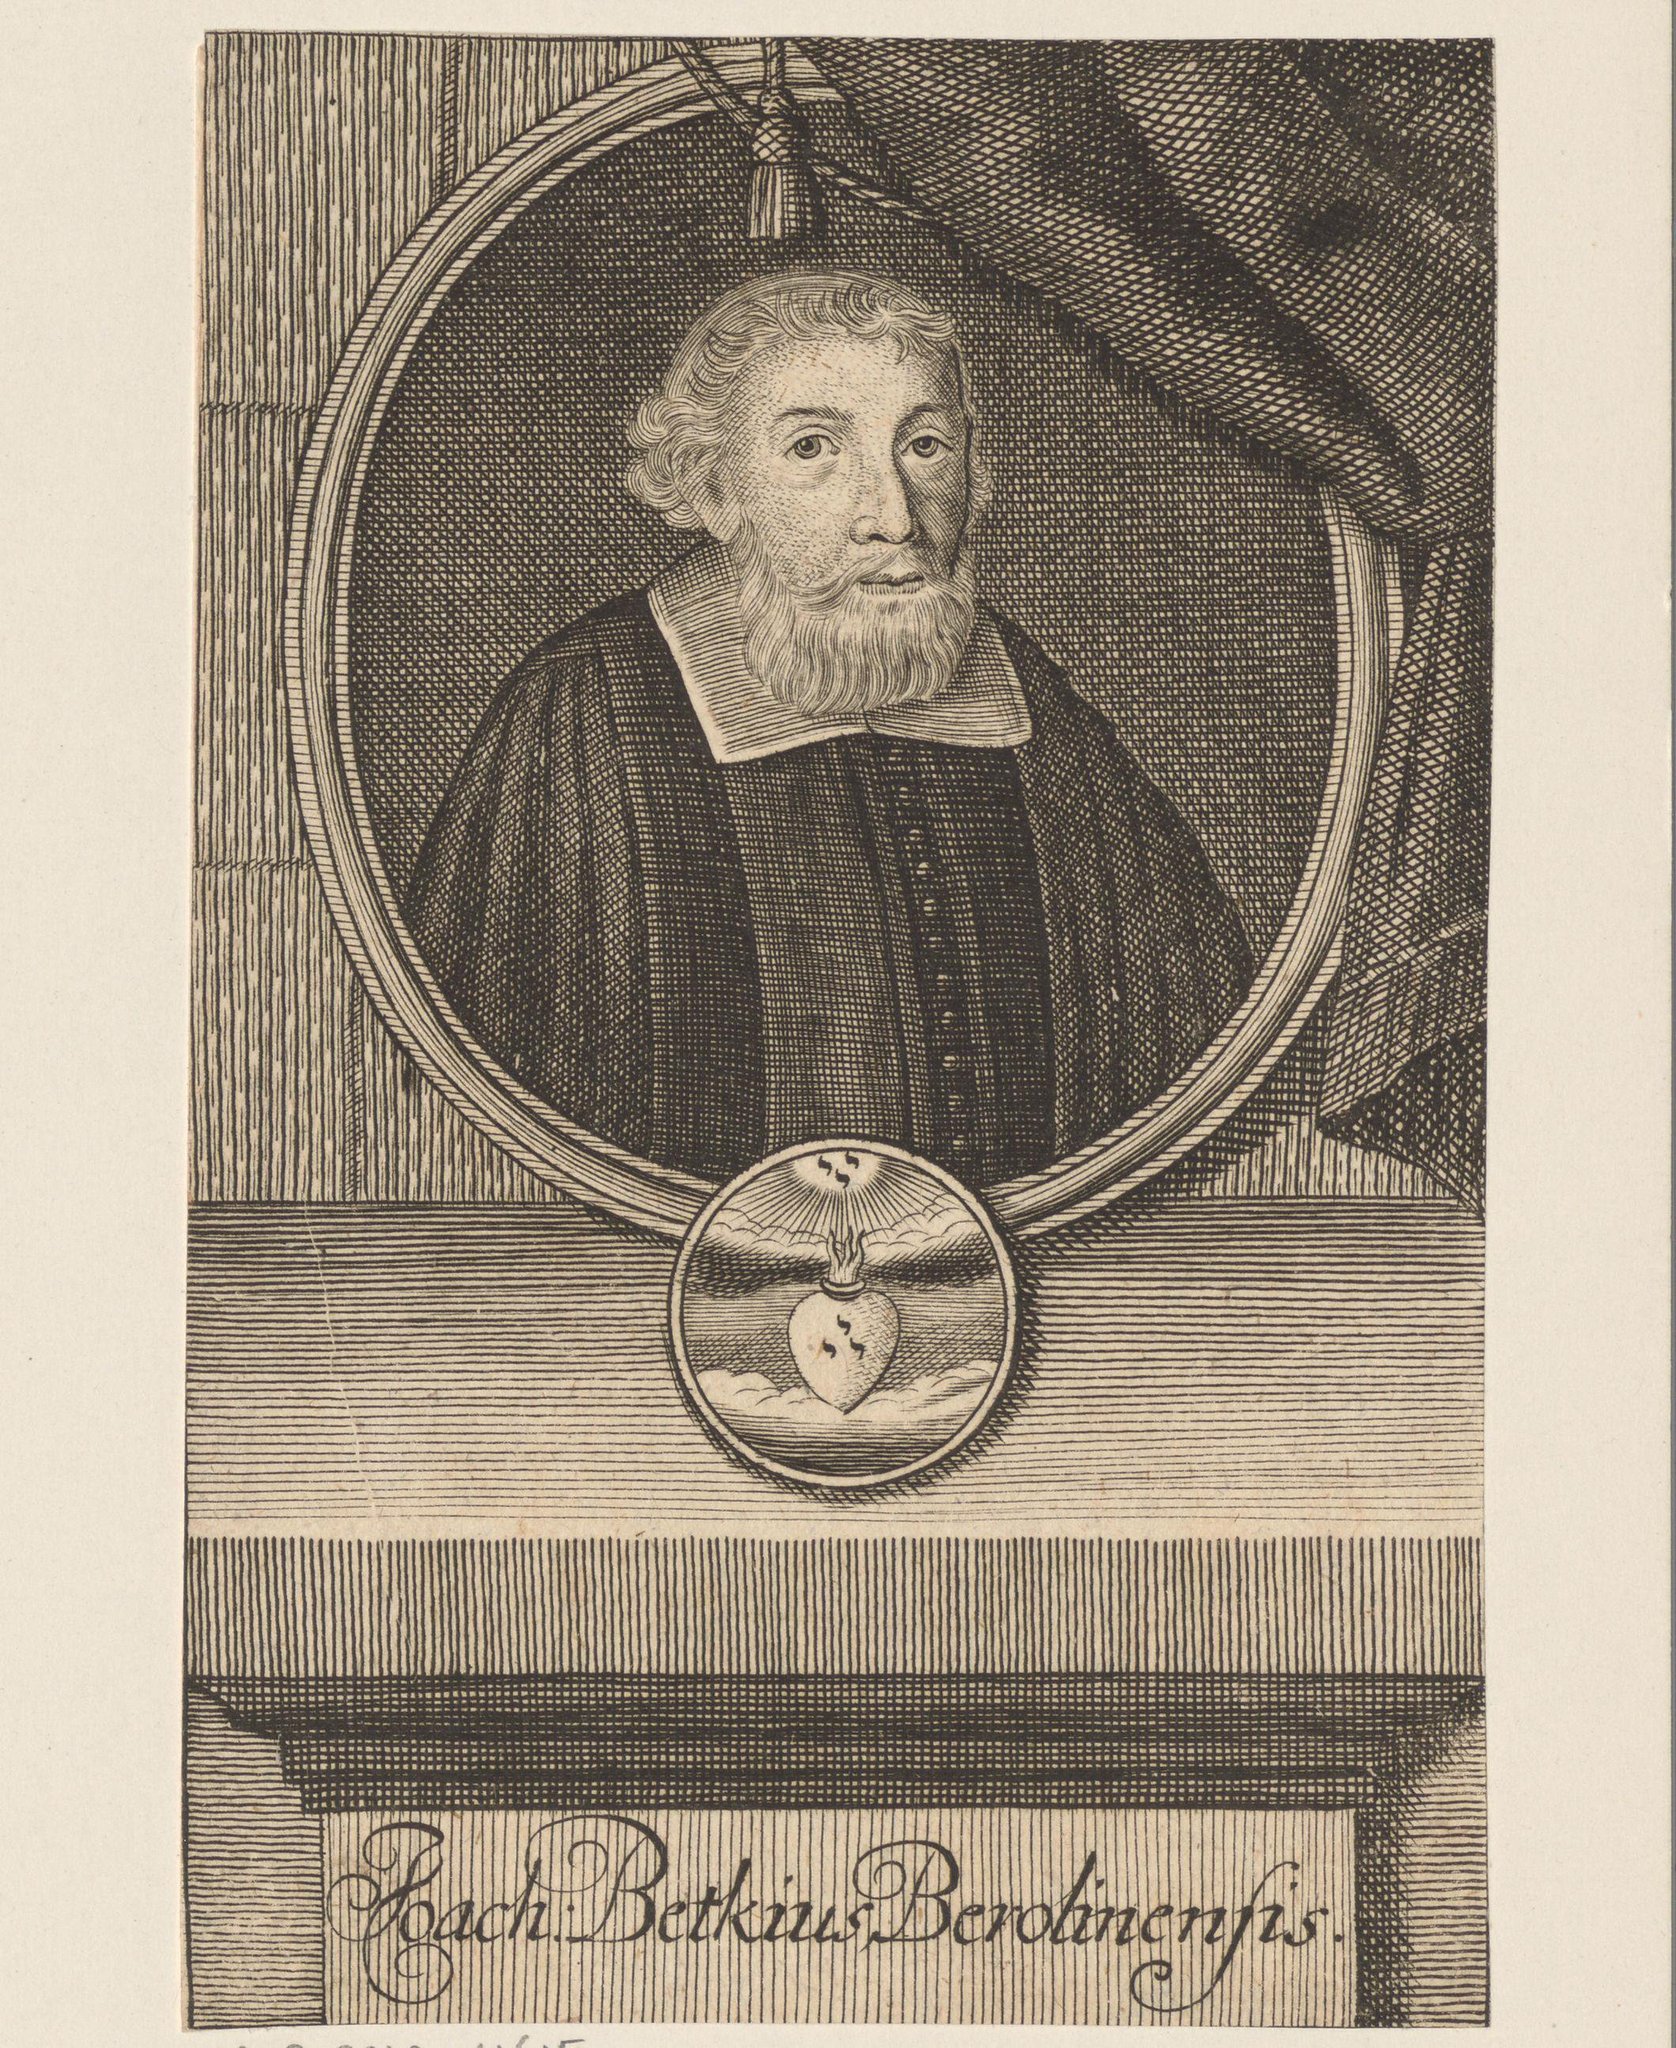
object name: print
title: Portret van Joachim Betke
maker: Anonymous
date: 1700-1749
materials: paper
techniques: engraving, etching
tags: theologian, historical persons, armorial bearing, heraldry